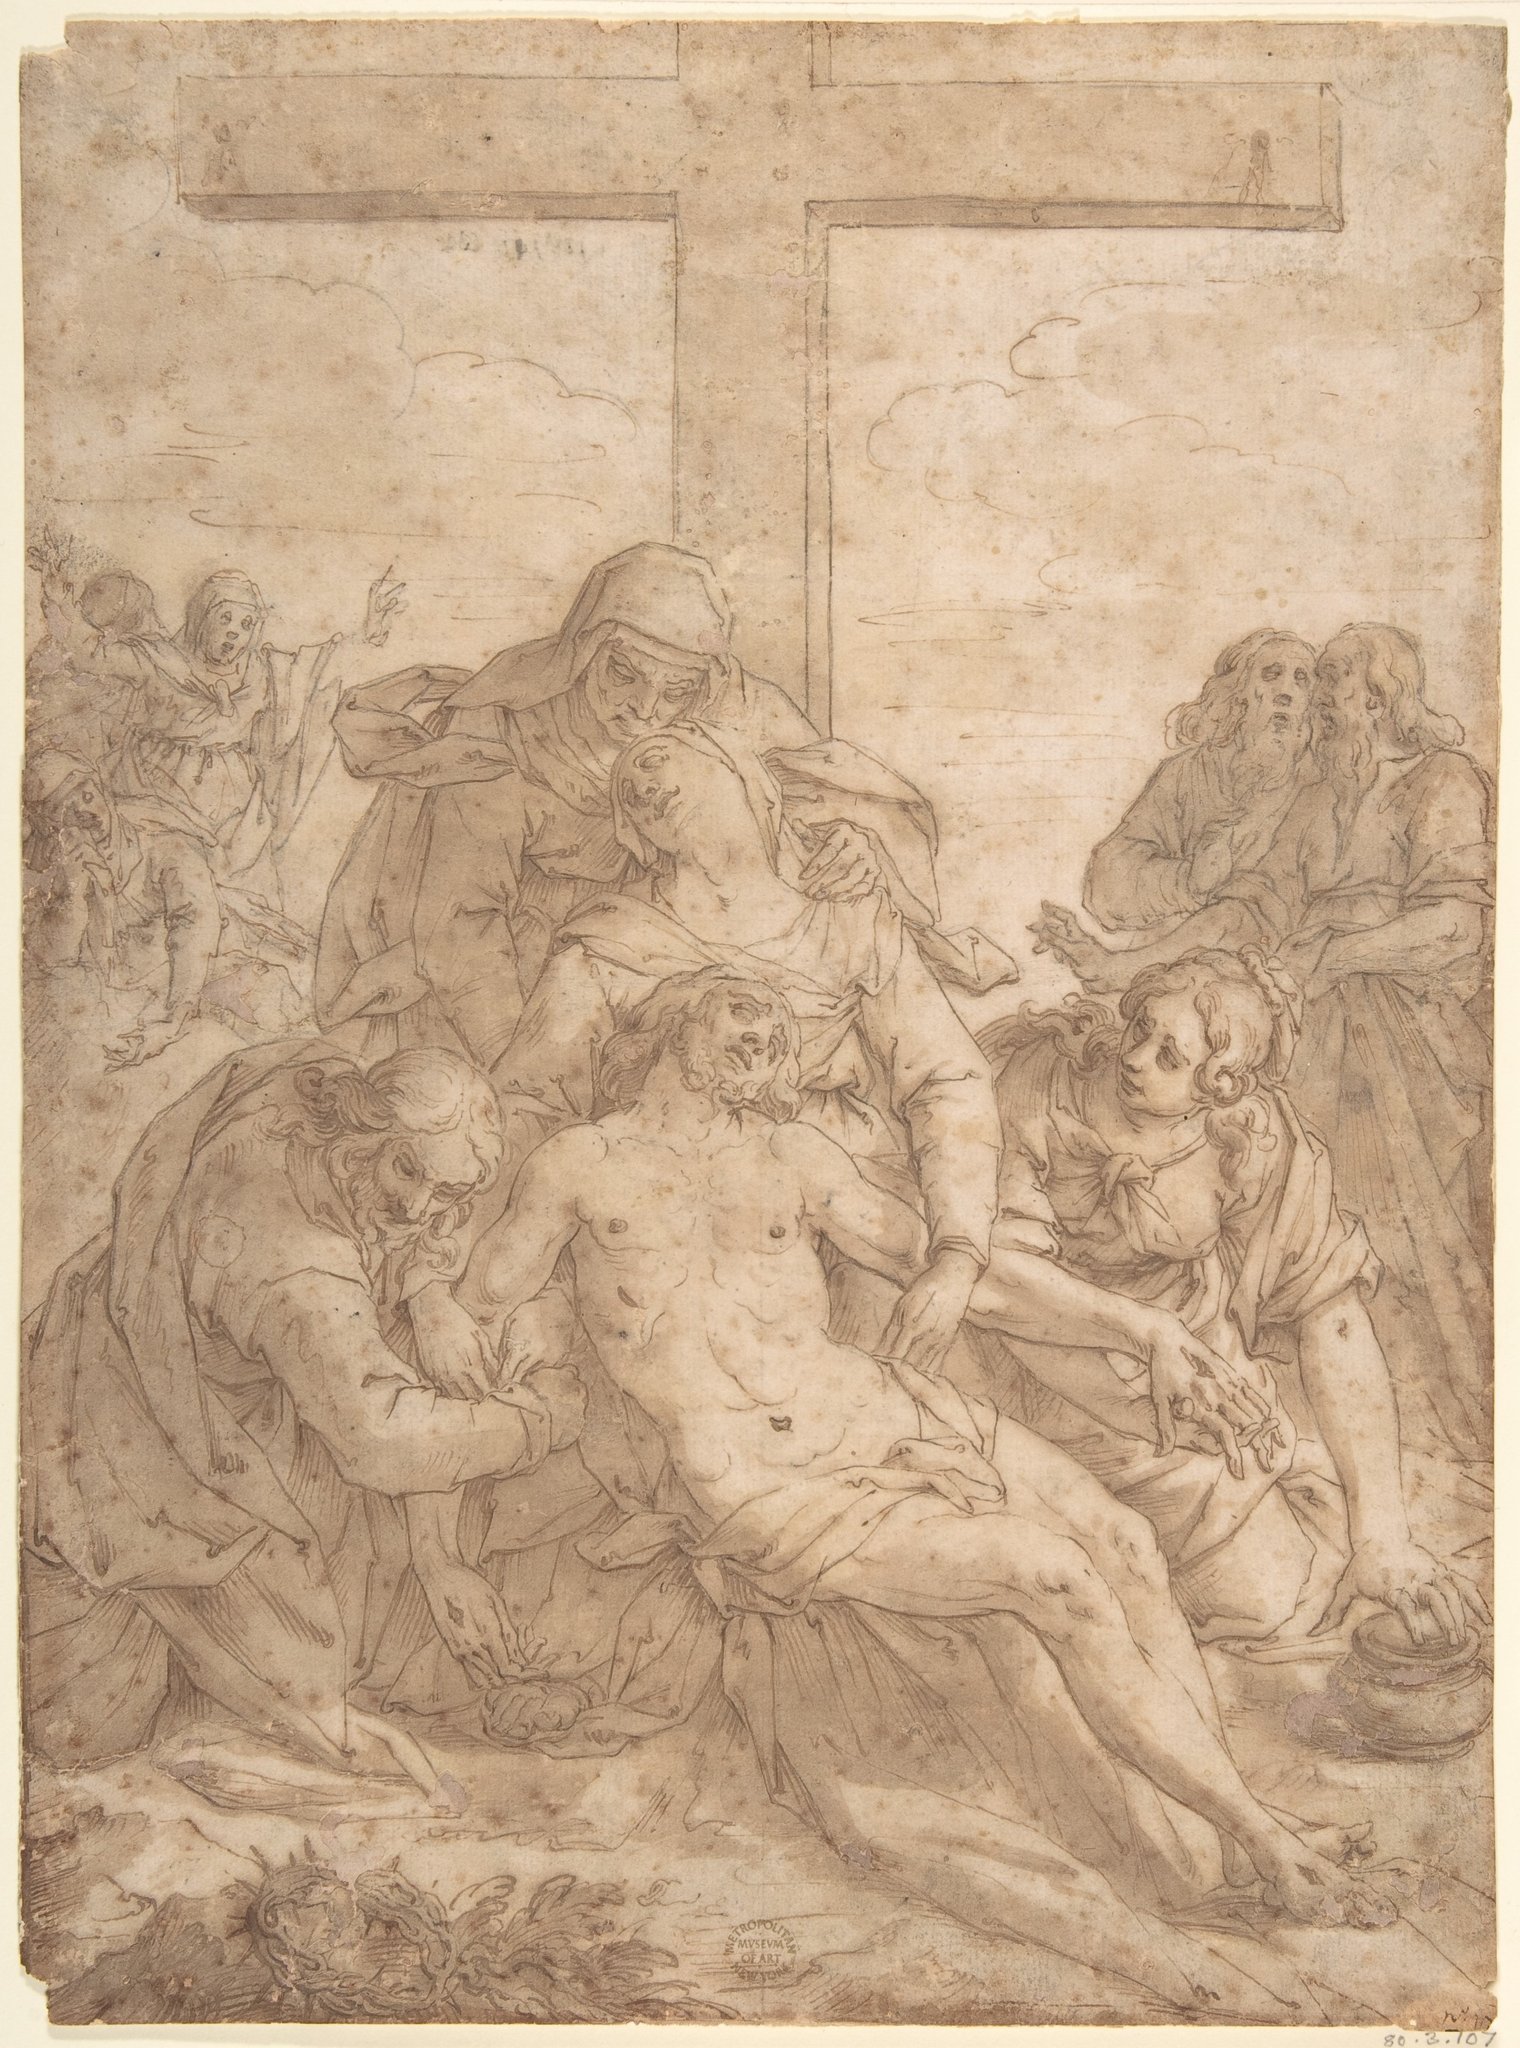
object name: drawing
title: Descent from the Cross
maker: pasquale ottino (pasqualotto)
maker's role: artist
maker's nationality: italian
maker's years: 1578-1630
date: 1615-1616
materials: ink, paper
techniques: brush, pen, wash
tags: men,women,christ,virgin mary,cross